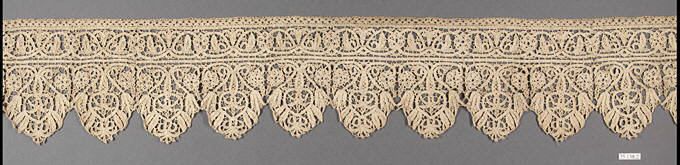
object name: border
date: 1601-1700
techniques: lace